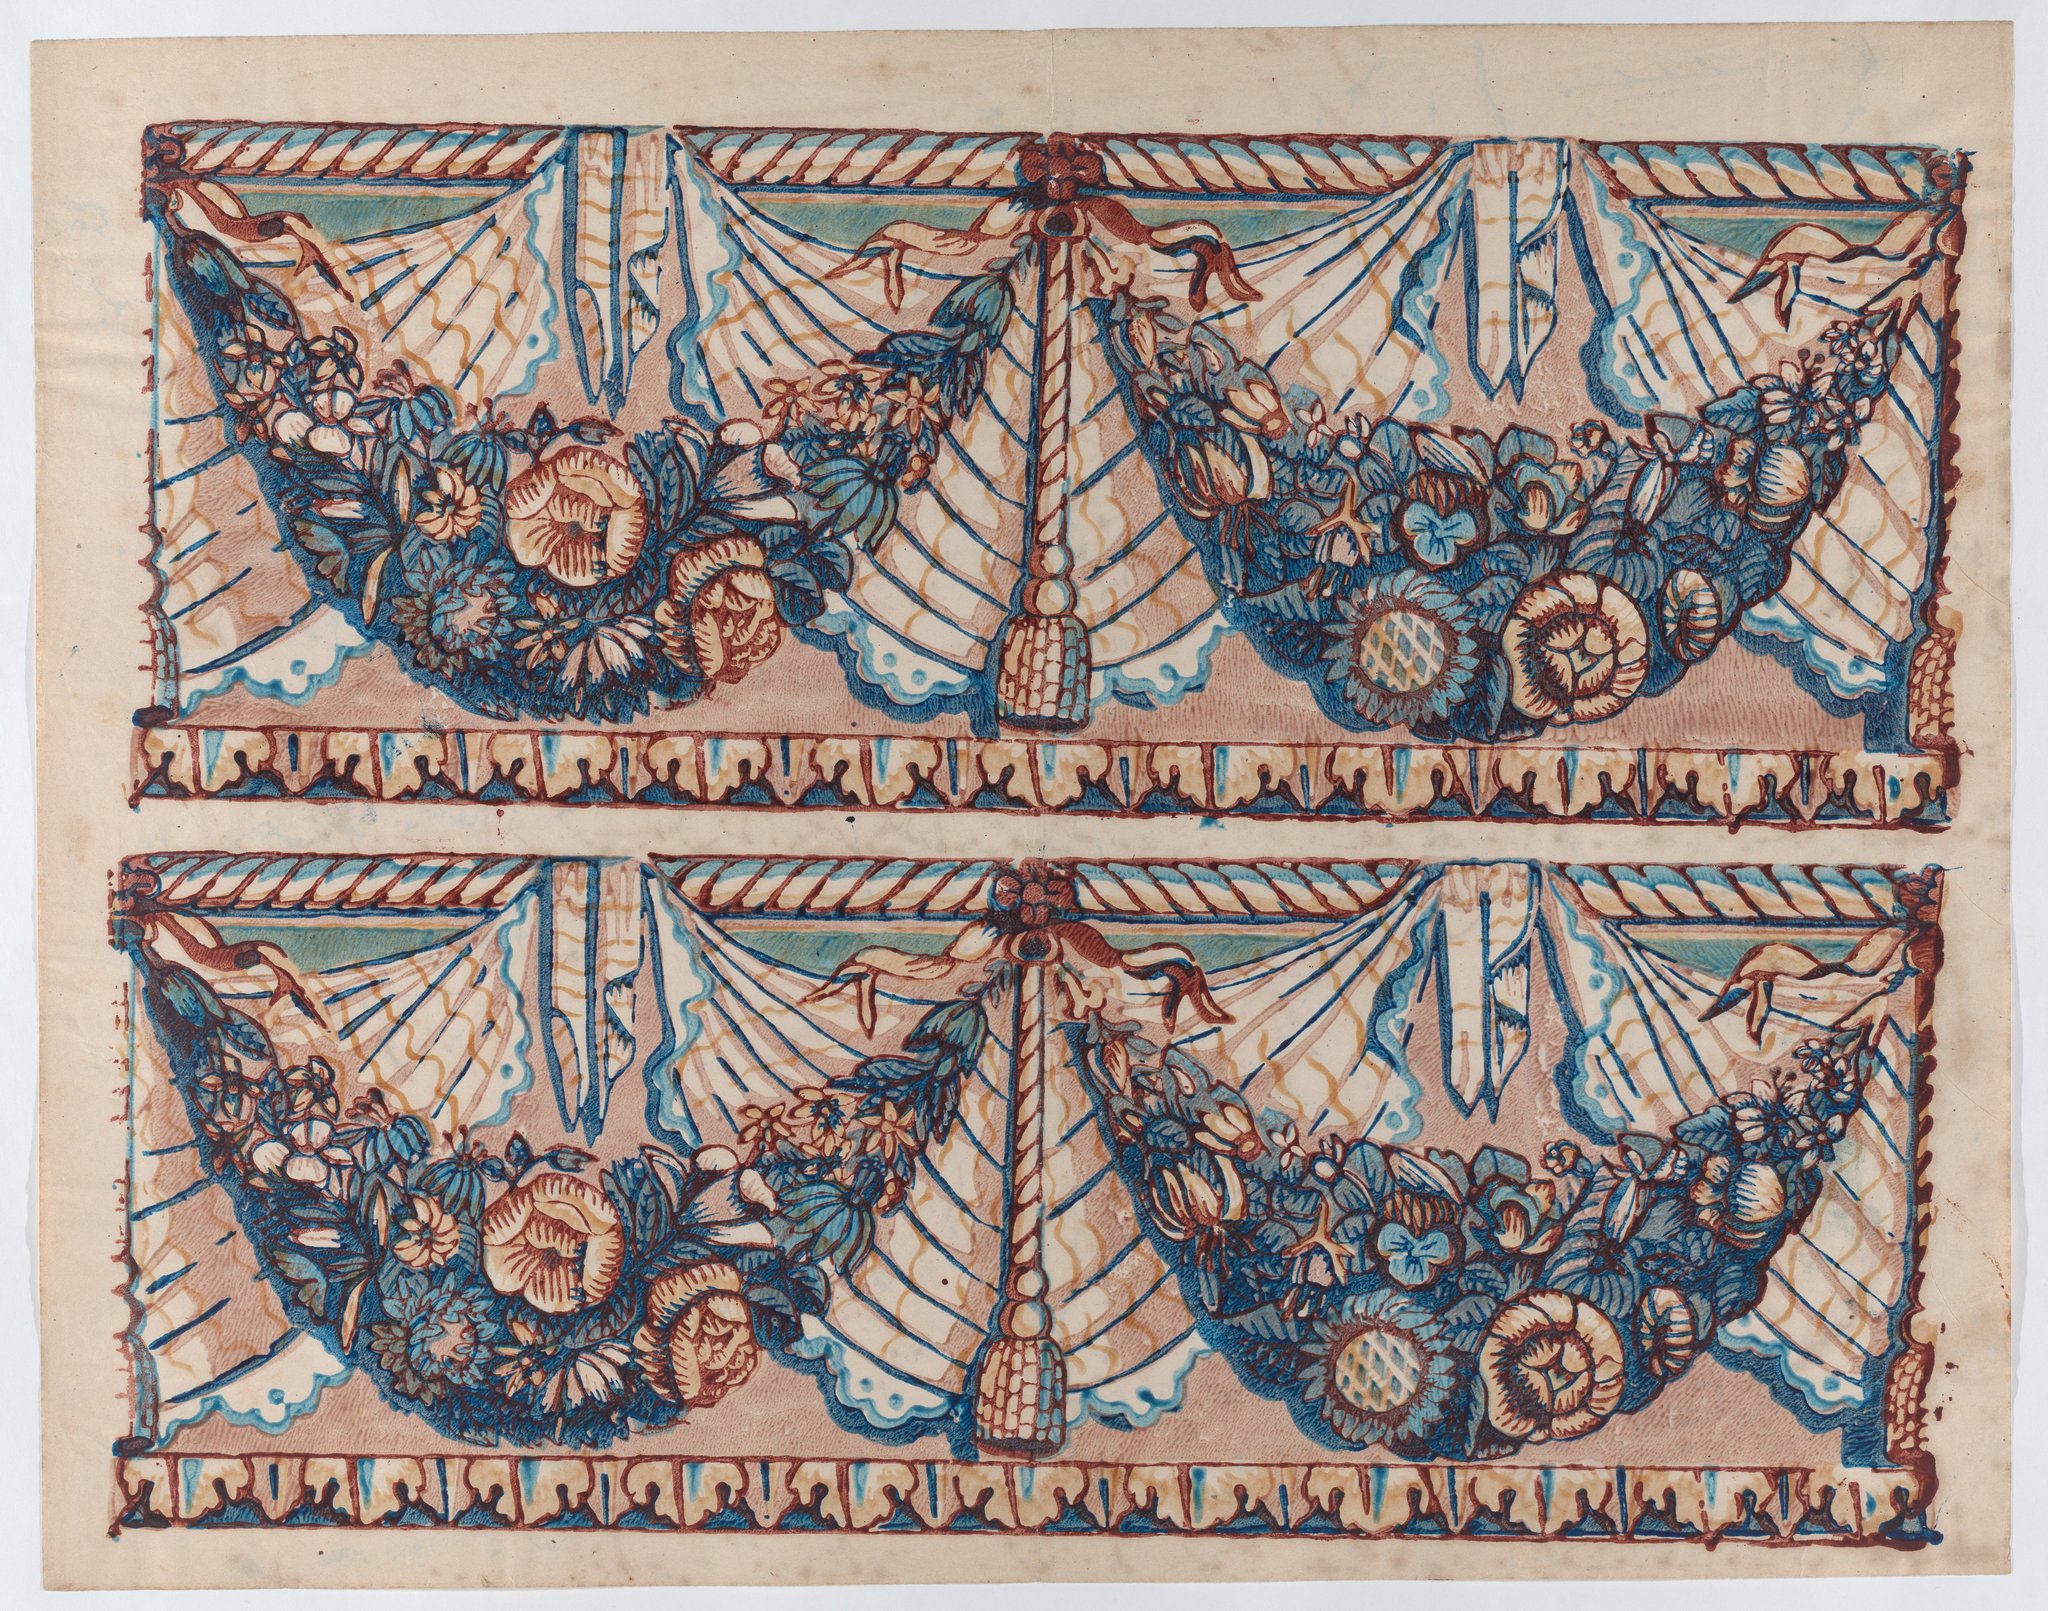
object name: print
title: Sheet with a two borders with hanging drapery and two blue floral garlands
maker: Anonymous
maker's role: artist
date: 1767-1866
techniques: relief print